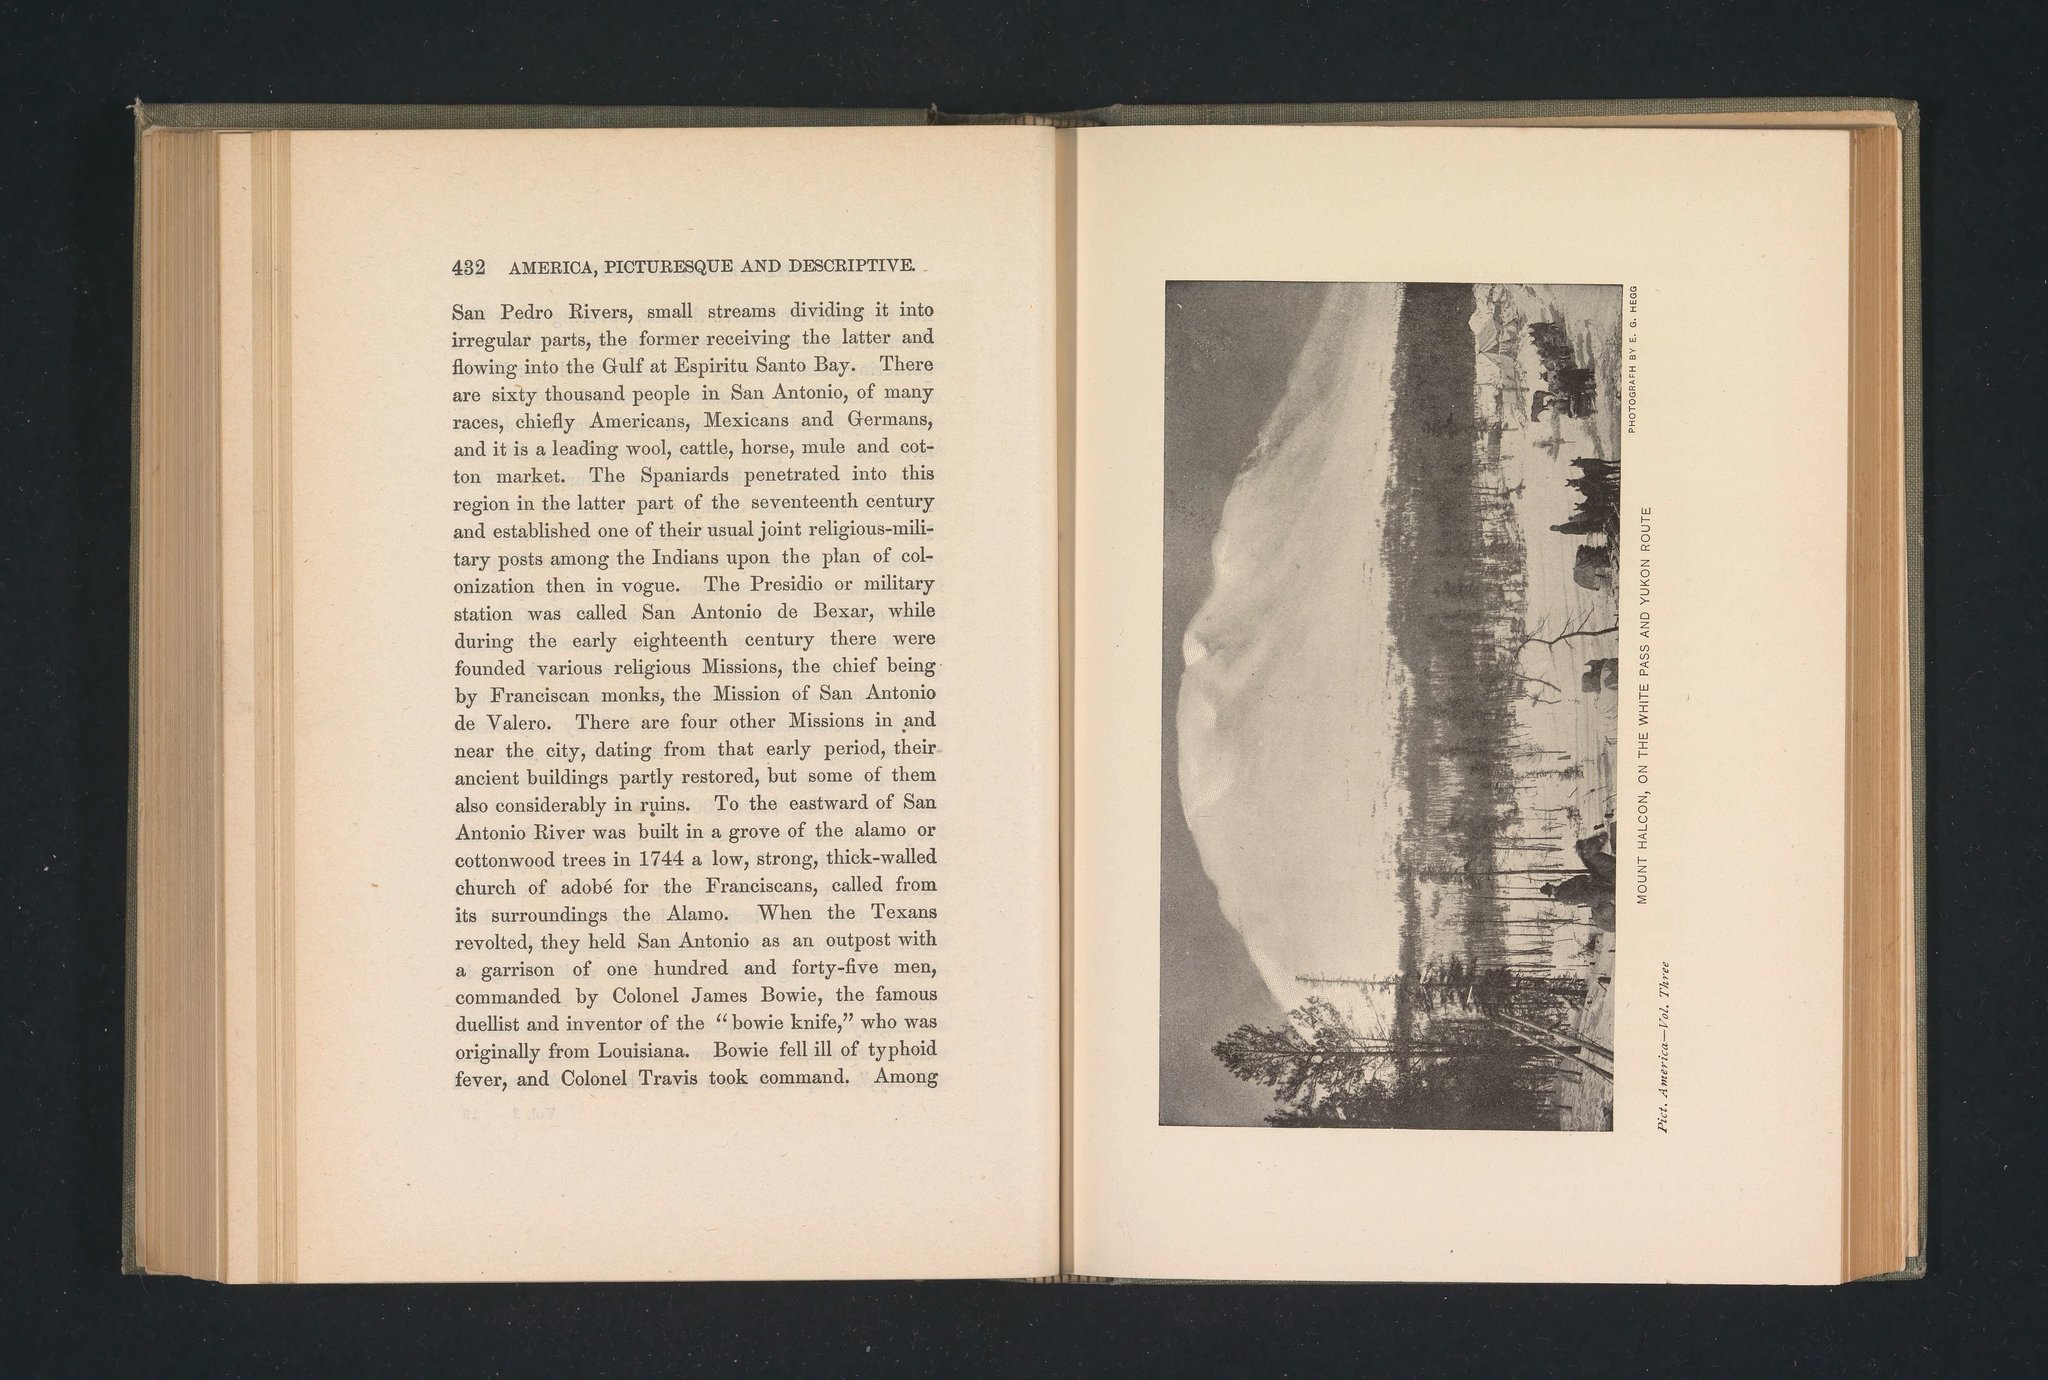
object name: page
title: Mount Halcon, on the White Pass and Yukon route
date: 1890-1900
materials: paper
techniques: autotype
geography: alaska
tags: mountains